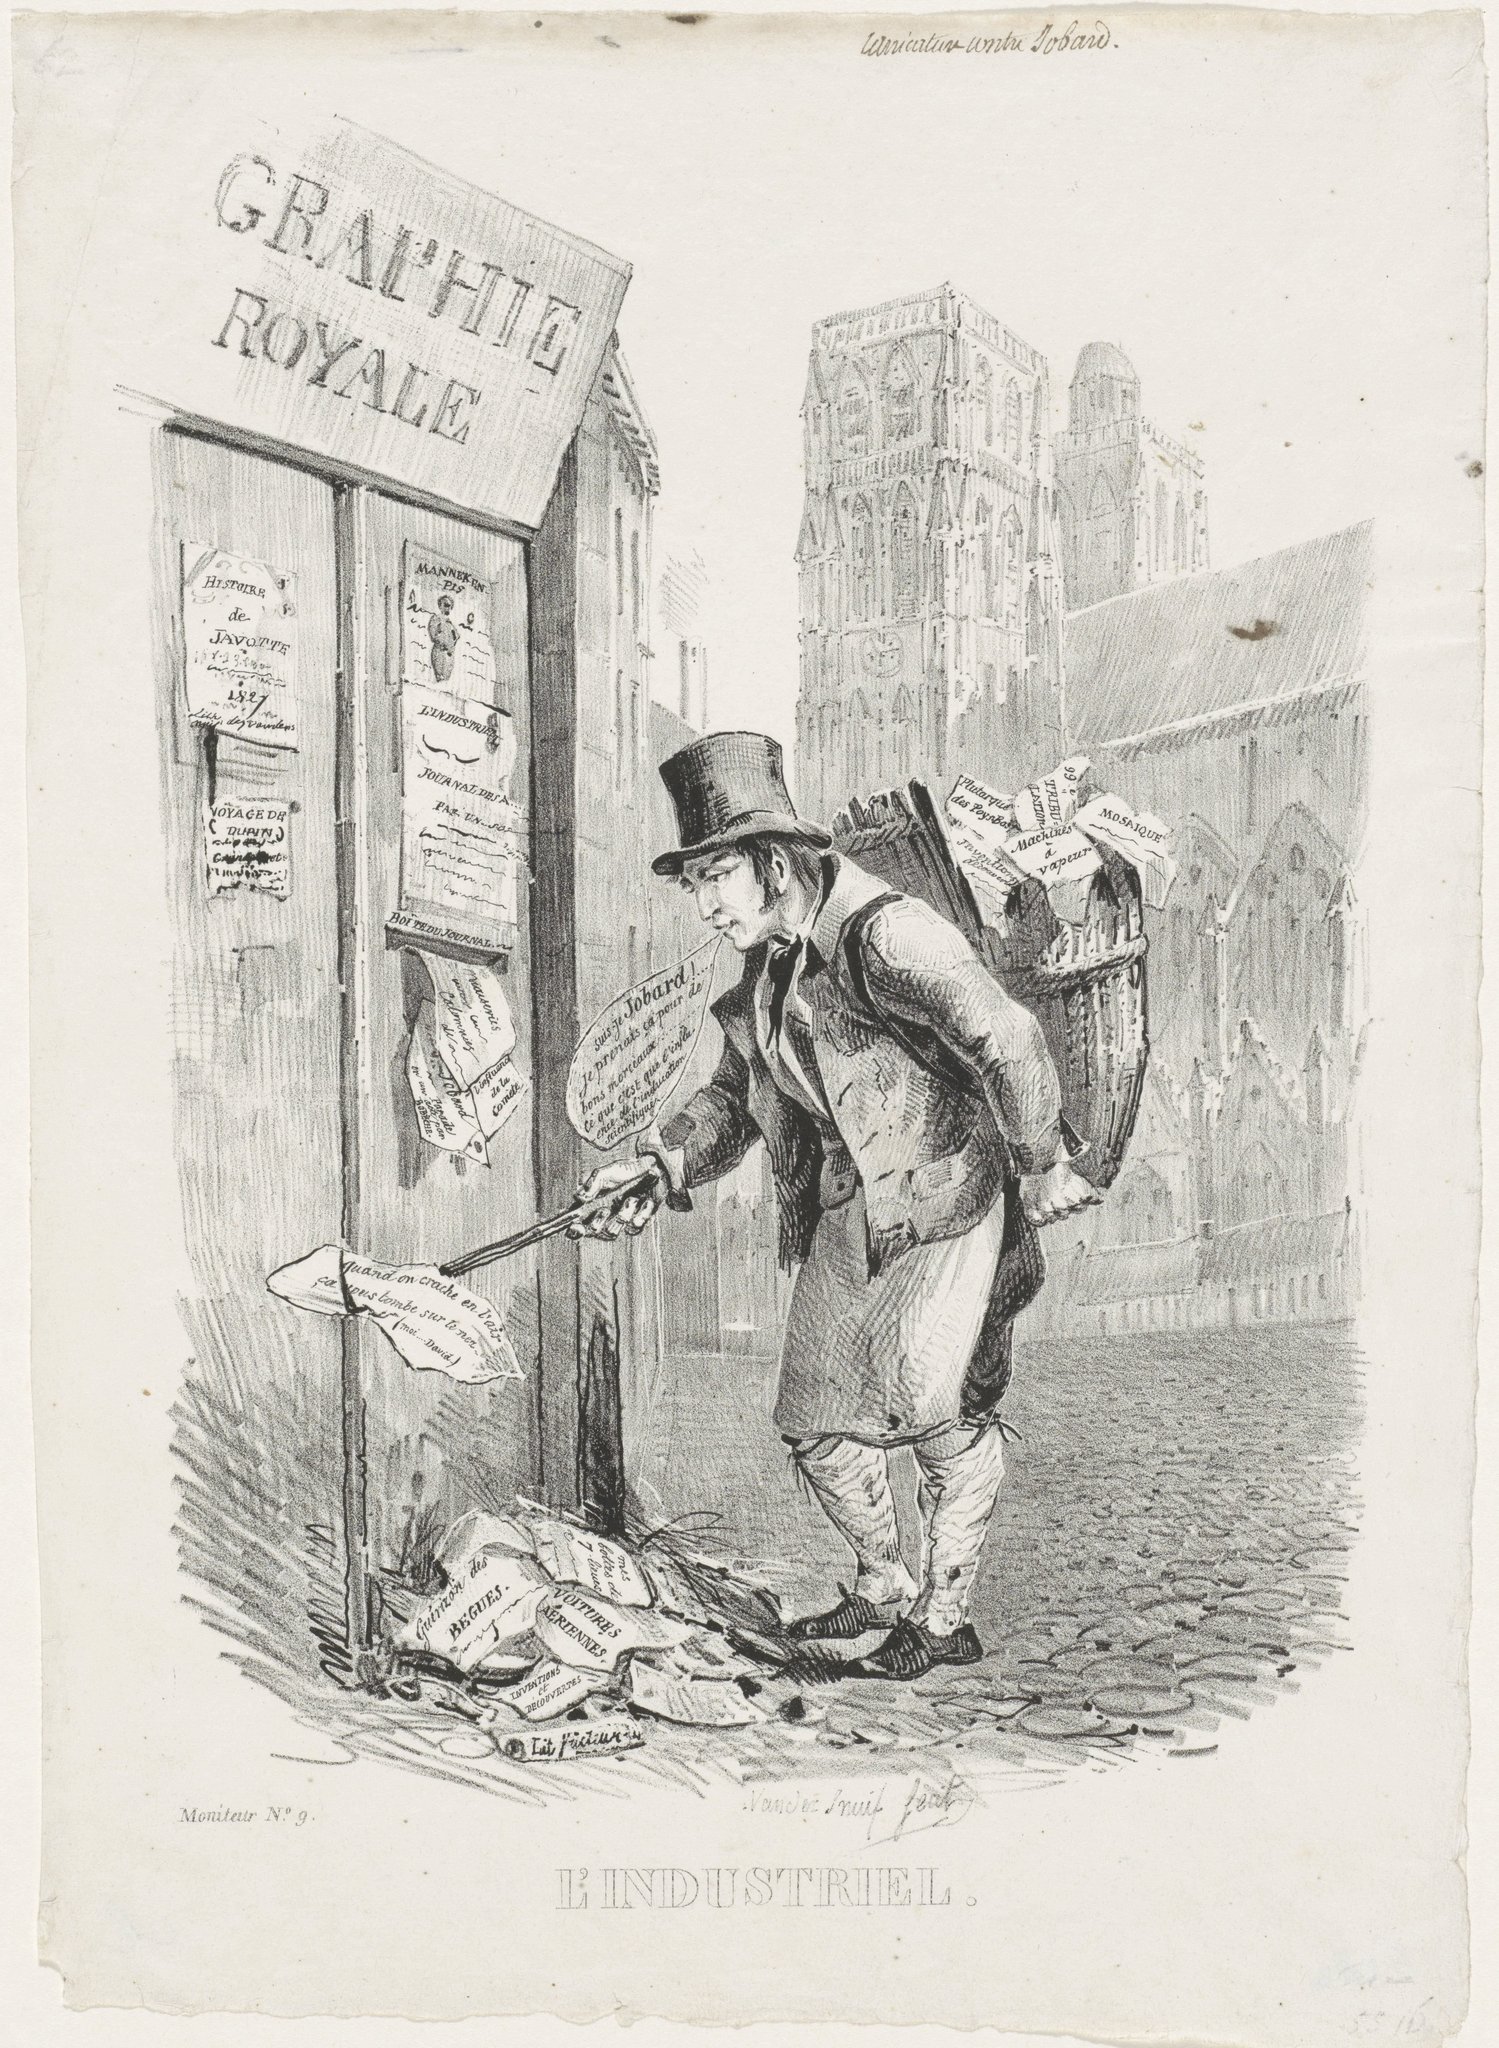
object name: print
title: L'Industriel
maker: Anonymous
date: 1827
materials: paper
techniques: lithograph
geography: netherlands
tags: printer, publisher, litter, rubbish, garbage ~ street sweeping, brussels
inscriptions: collector's mark: Lugt 2228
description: Spotprent op de steendrukker en uitgever van het tijdschrift l'Industriel, Jean Baptiste Ambroise Marcellin Jobard te Brussel, 1827. Jobard voorgesteld als voddenraper met een mand op de rug die op straat en van een muur allerlei stukken papier van zijn eigen uitgaven en uitvindingen raapt. Linksboven is een deel van het uithangbord van de zaak van Jobard te zien. Linksonder 'Moniteur No. 9'.